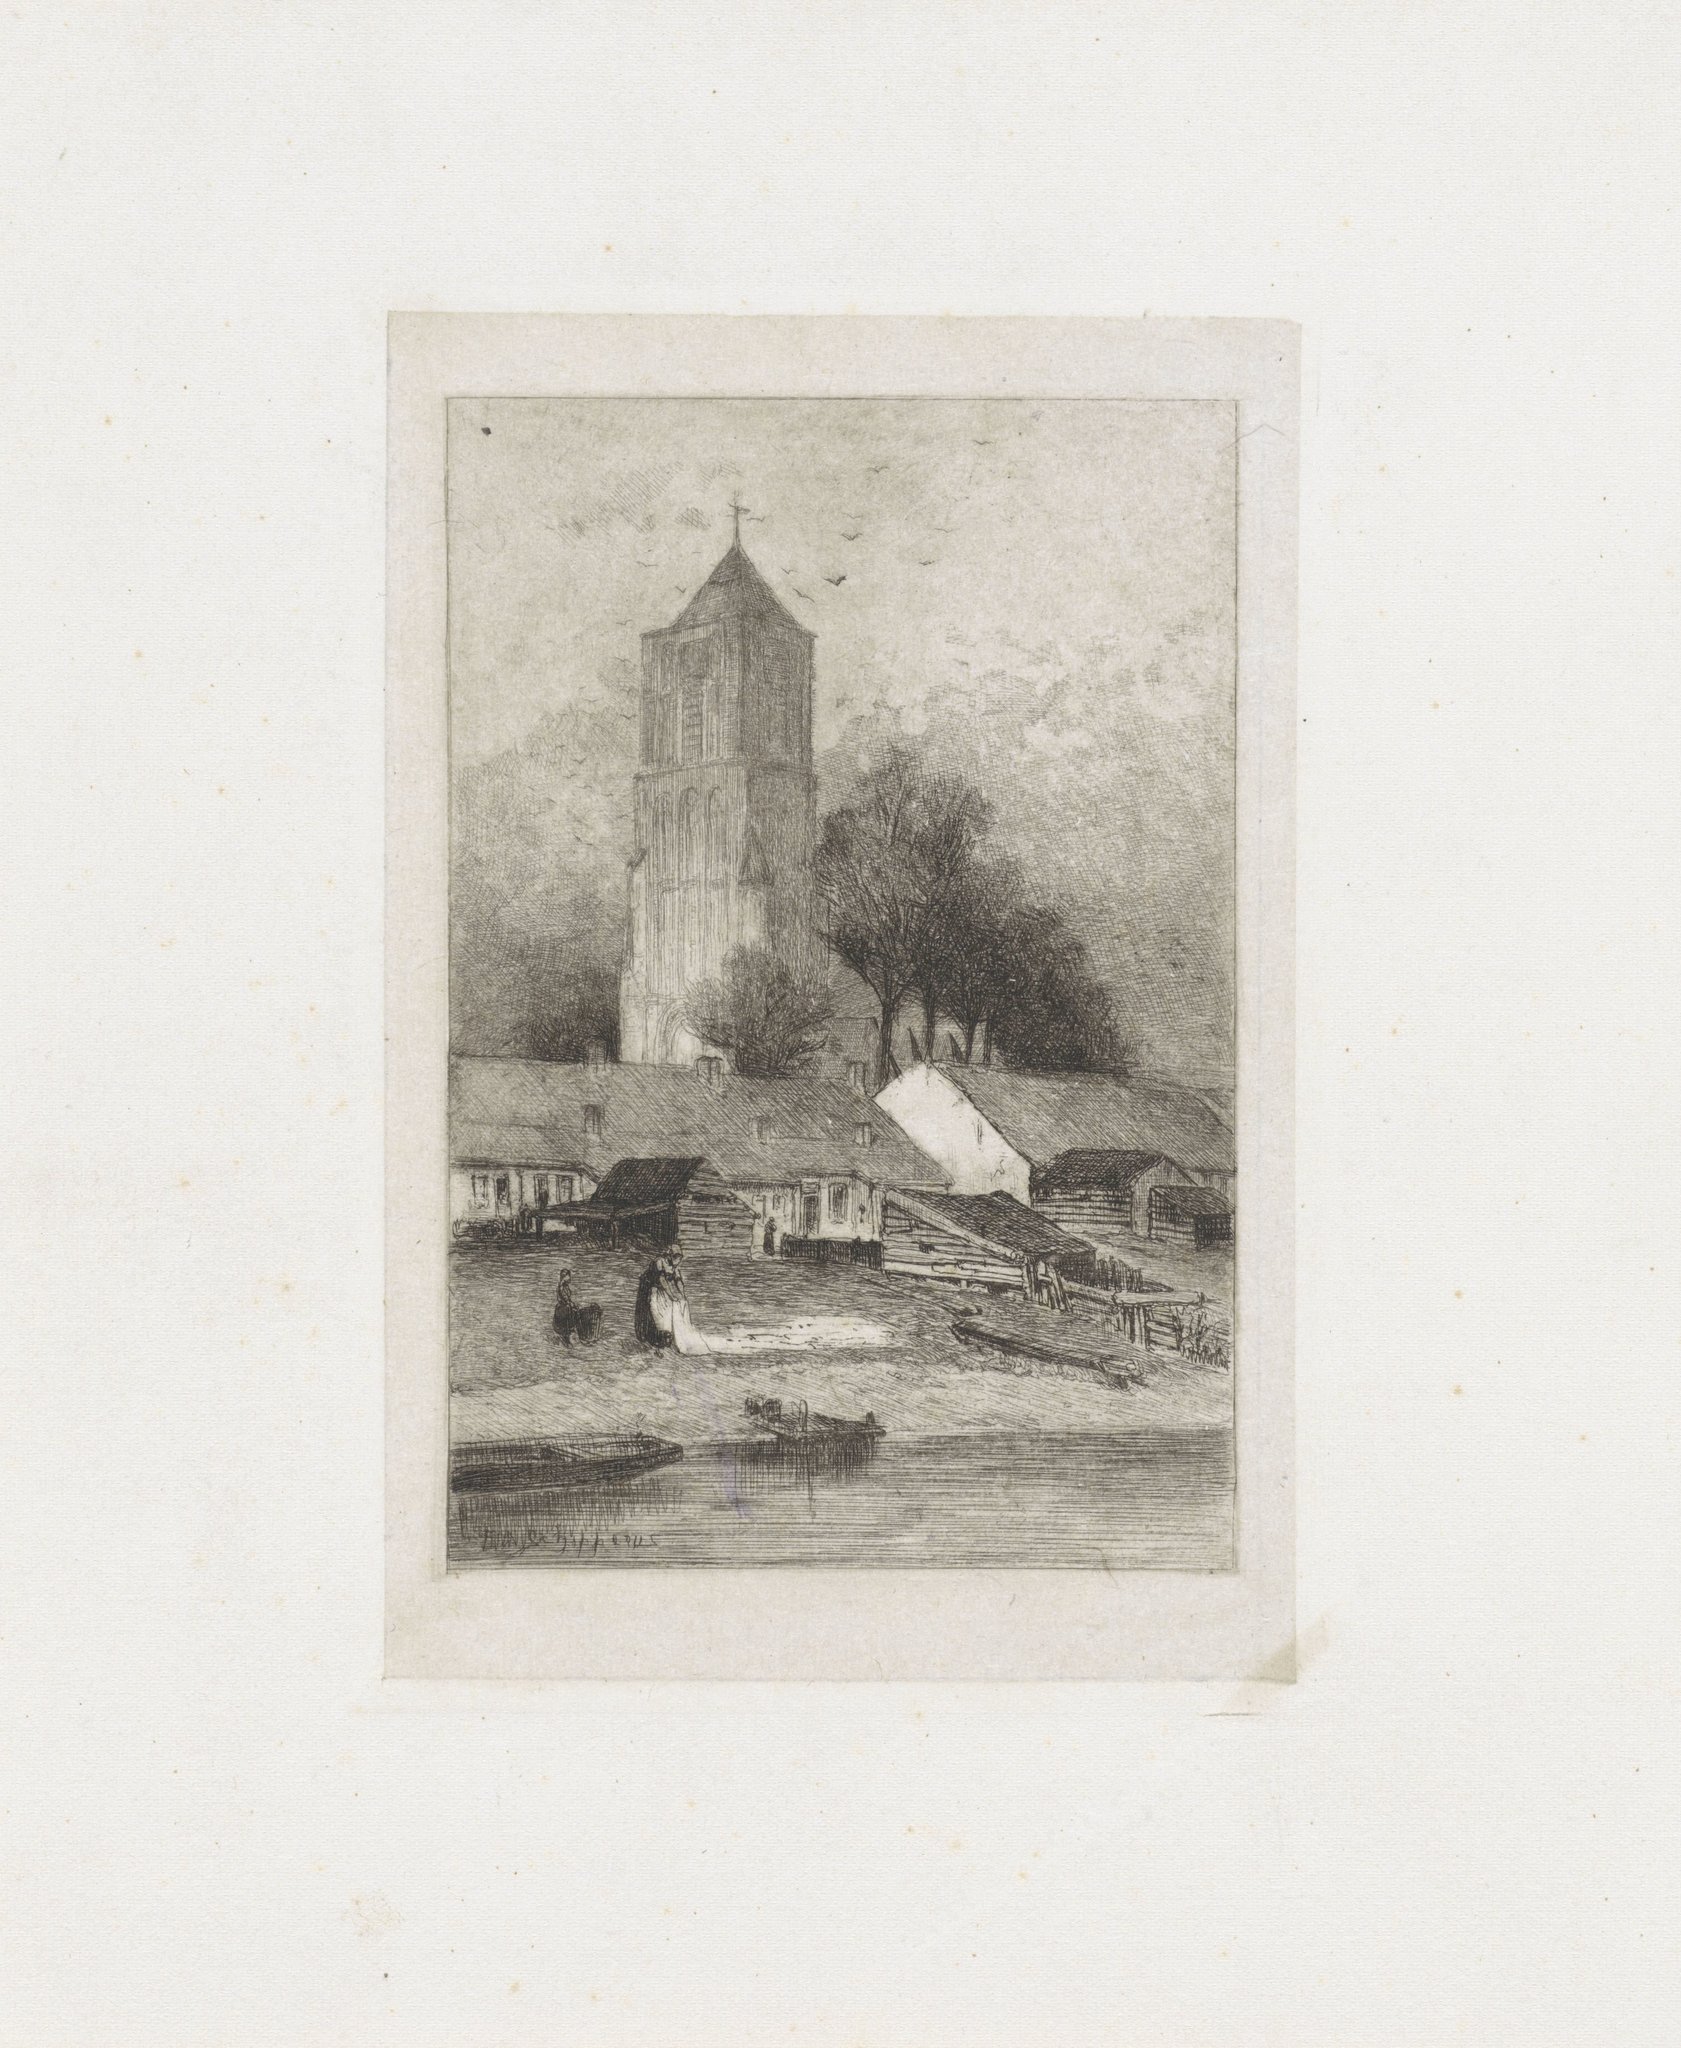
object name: print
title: Dorp met kerktoren aan het water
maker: piet schipperus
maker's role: draughtsman, print maker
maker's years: 1840-1929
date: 1850-1929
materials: paper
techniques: etching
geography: netherlands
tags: village, parts of church exterior and annexes: tower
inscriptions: collector's mark: Lugt 2760, collector's mark: Lugt 2228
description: Dorp met een kerktoren aan het water. Op de kant een vrouw die de was te drogen legt.